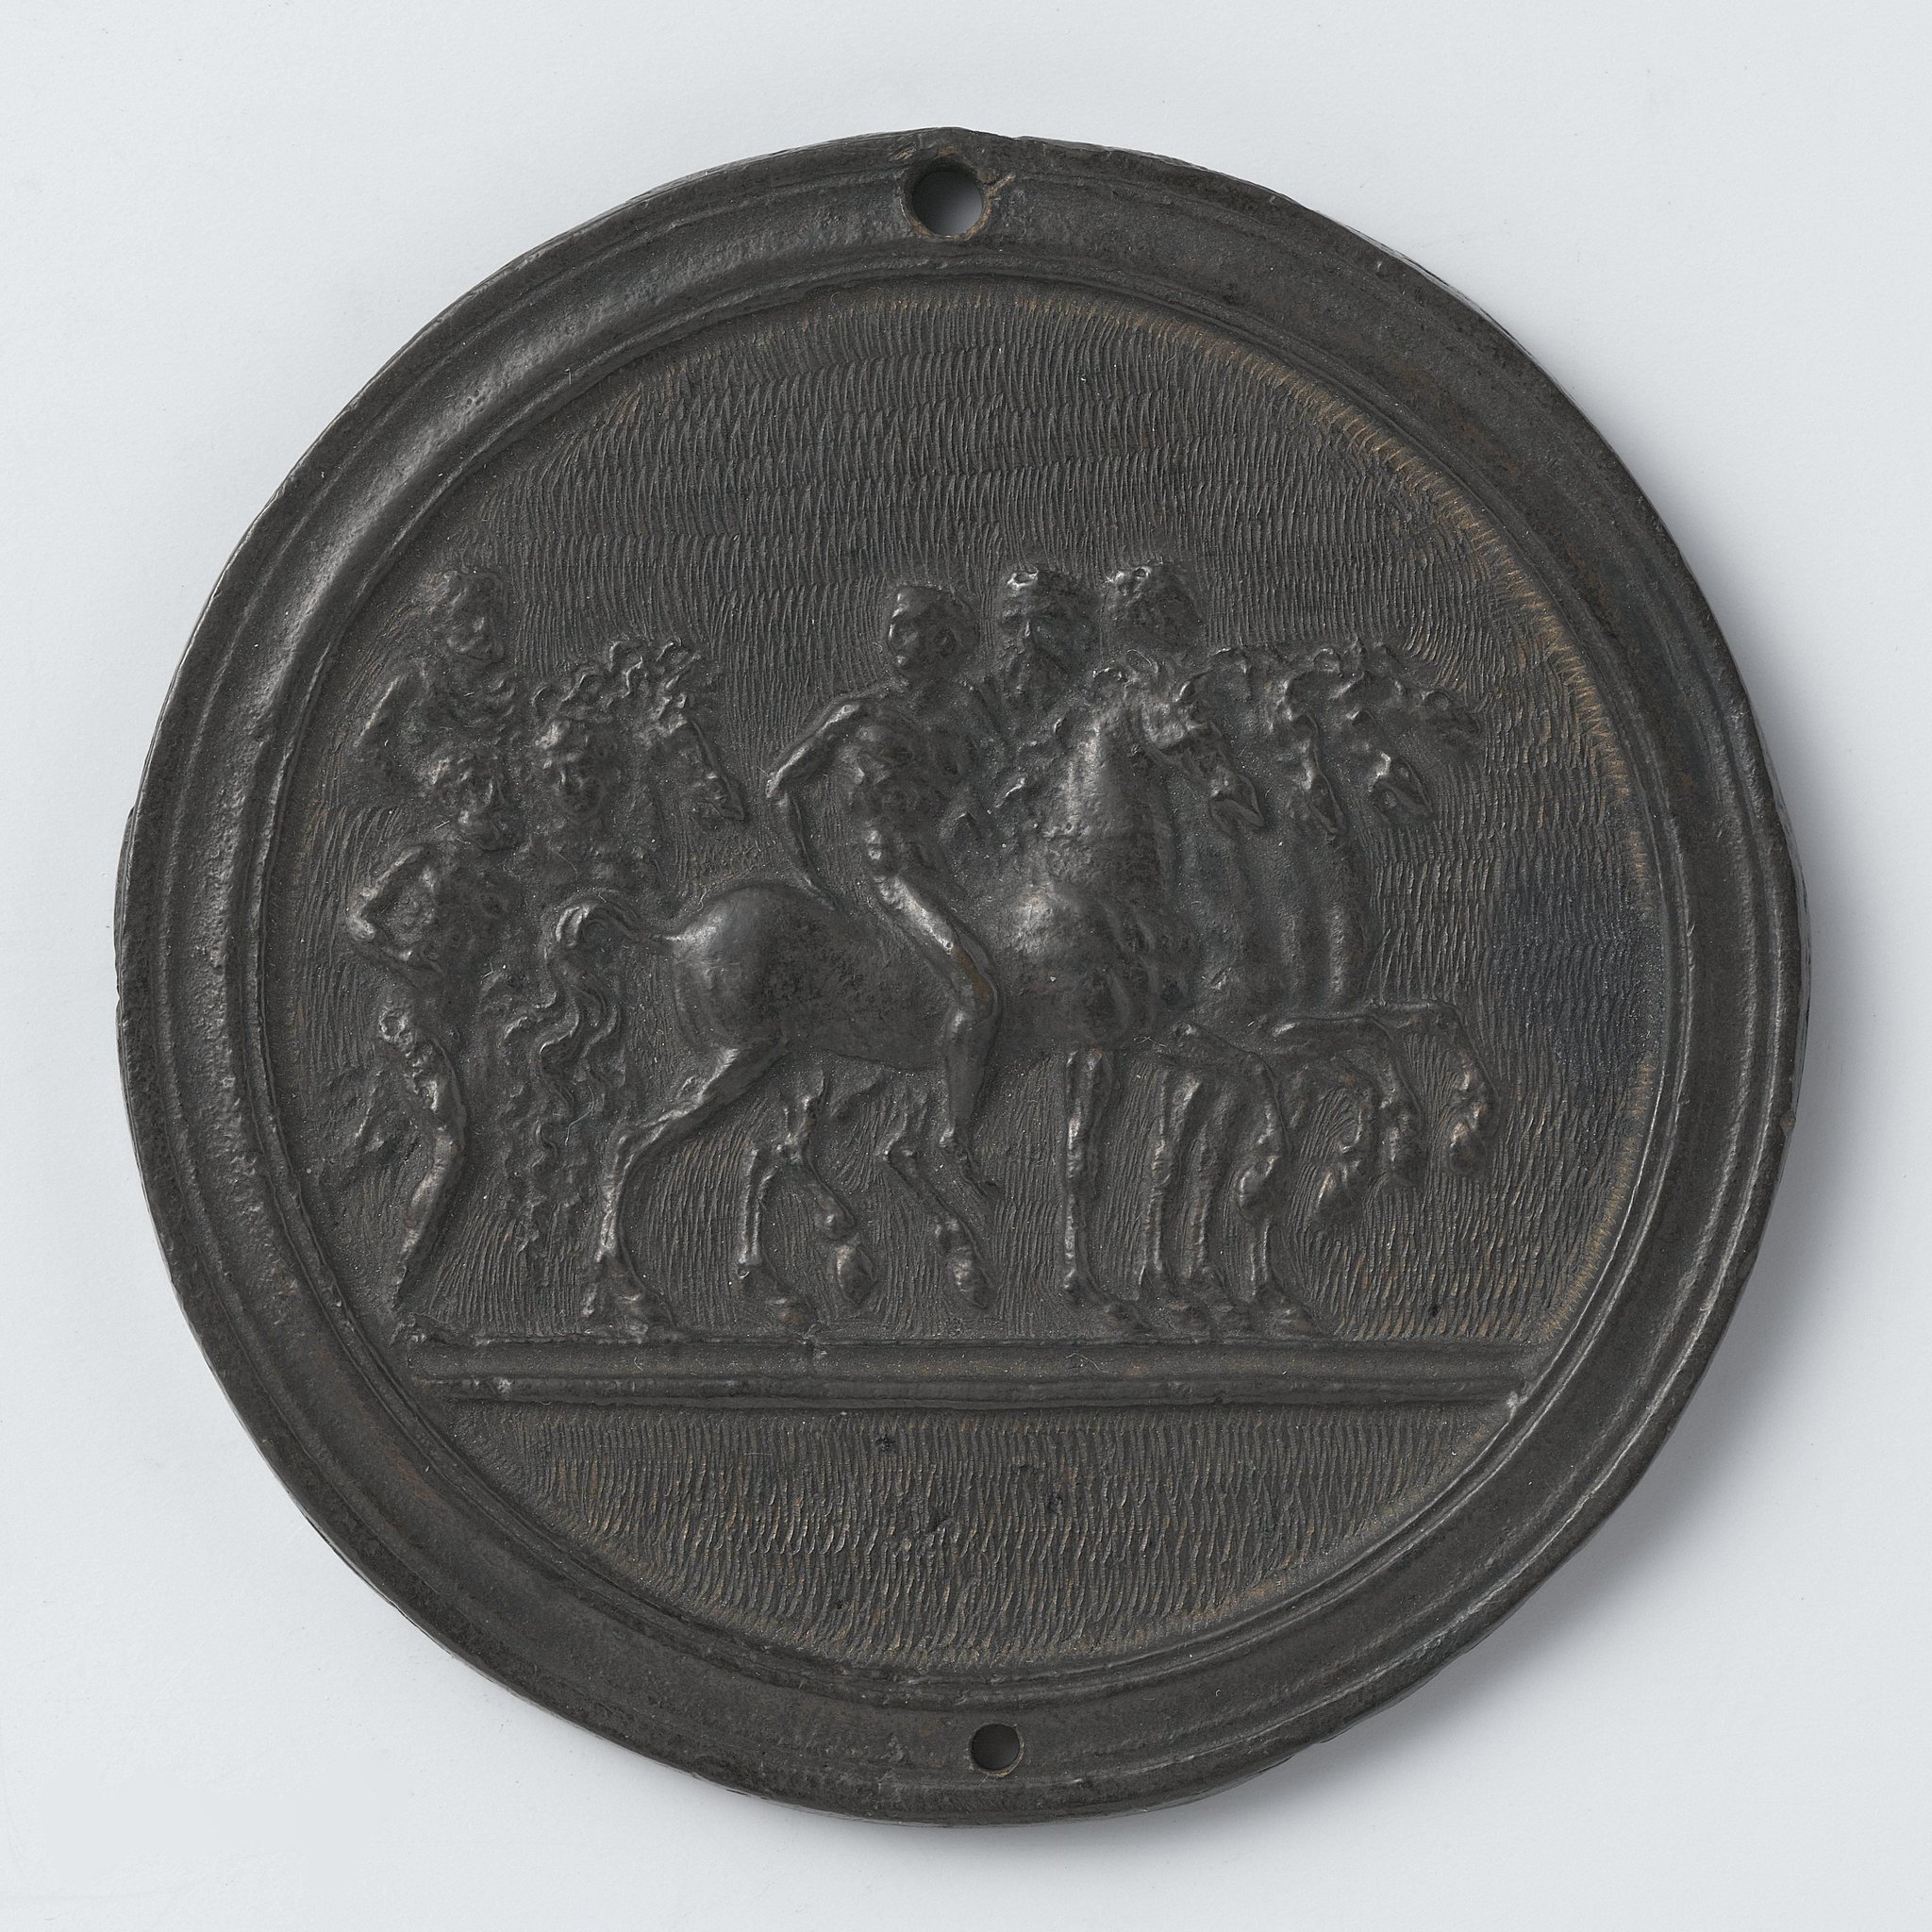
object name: sculpture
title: Coriolanus vertrekt uit Rome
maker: meester van coriolanus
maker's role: sculptor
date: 1500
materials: bronze